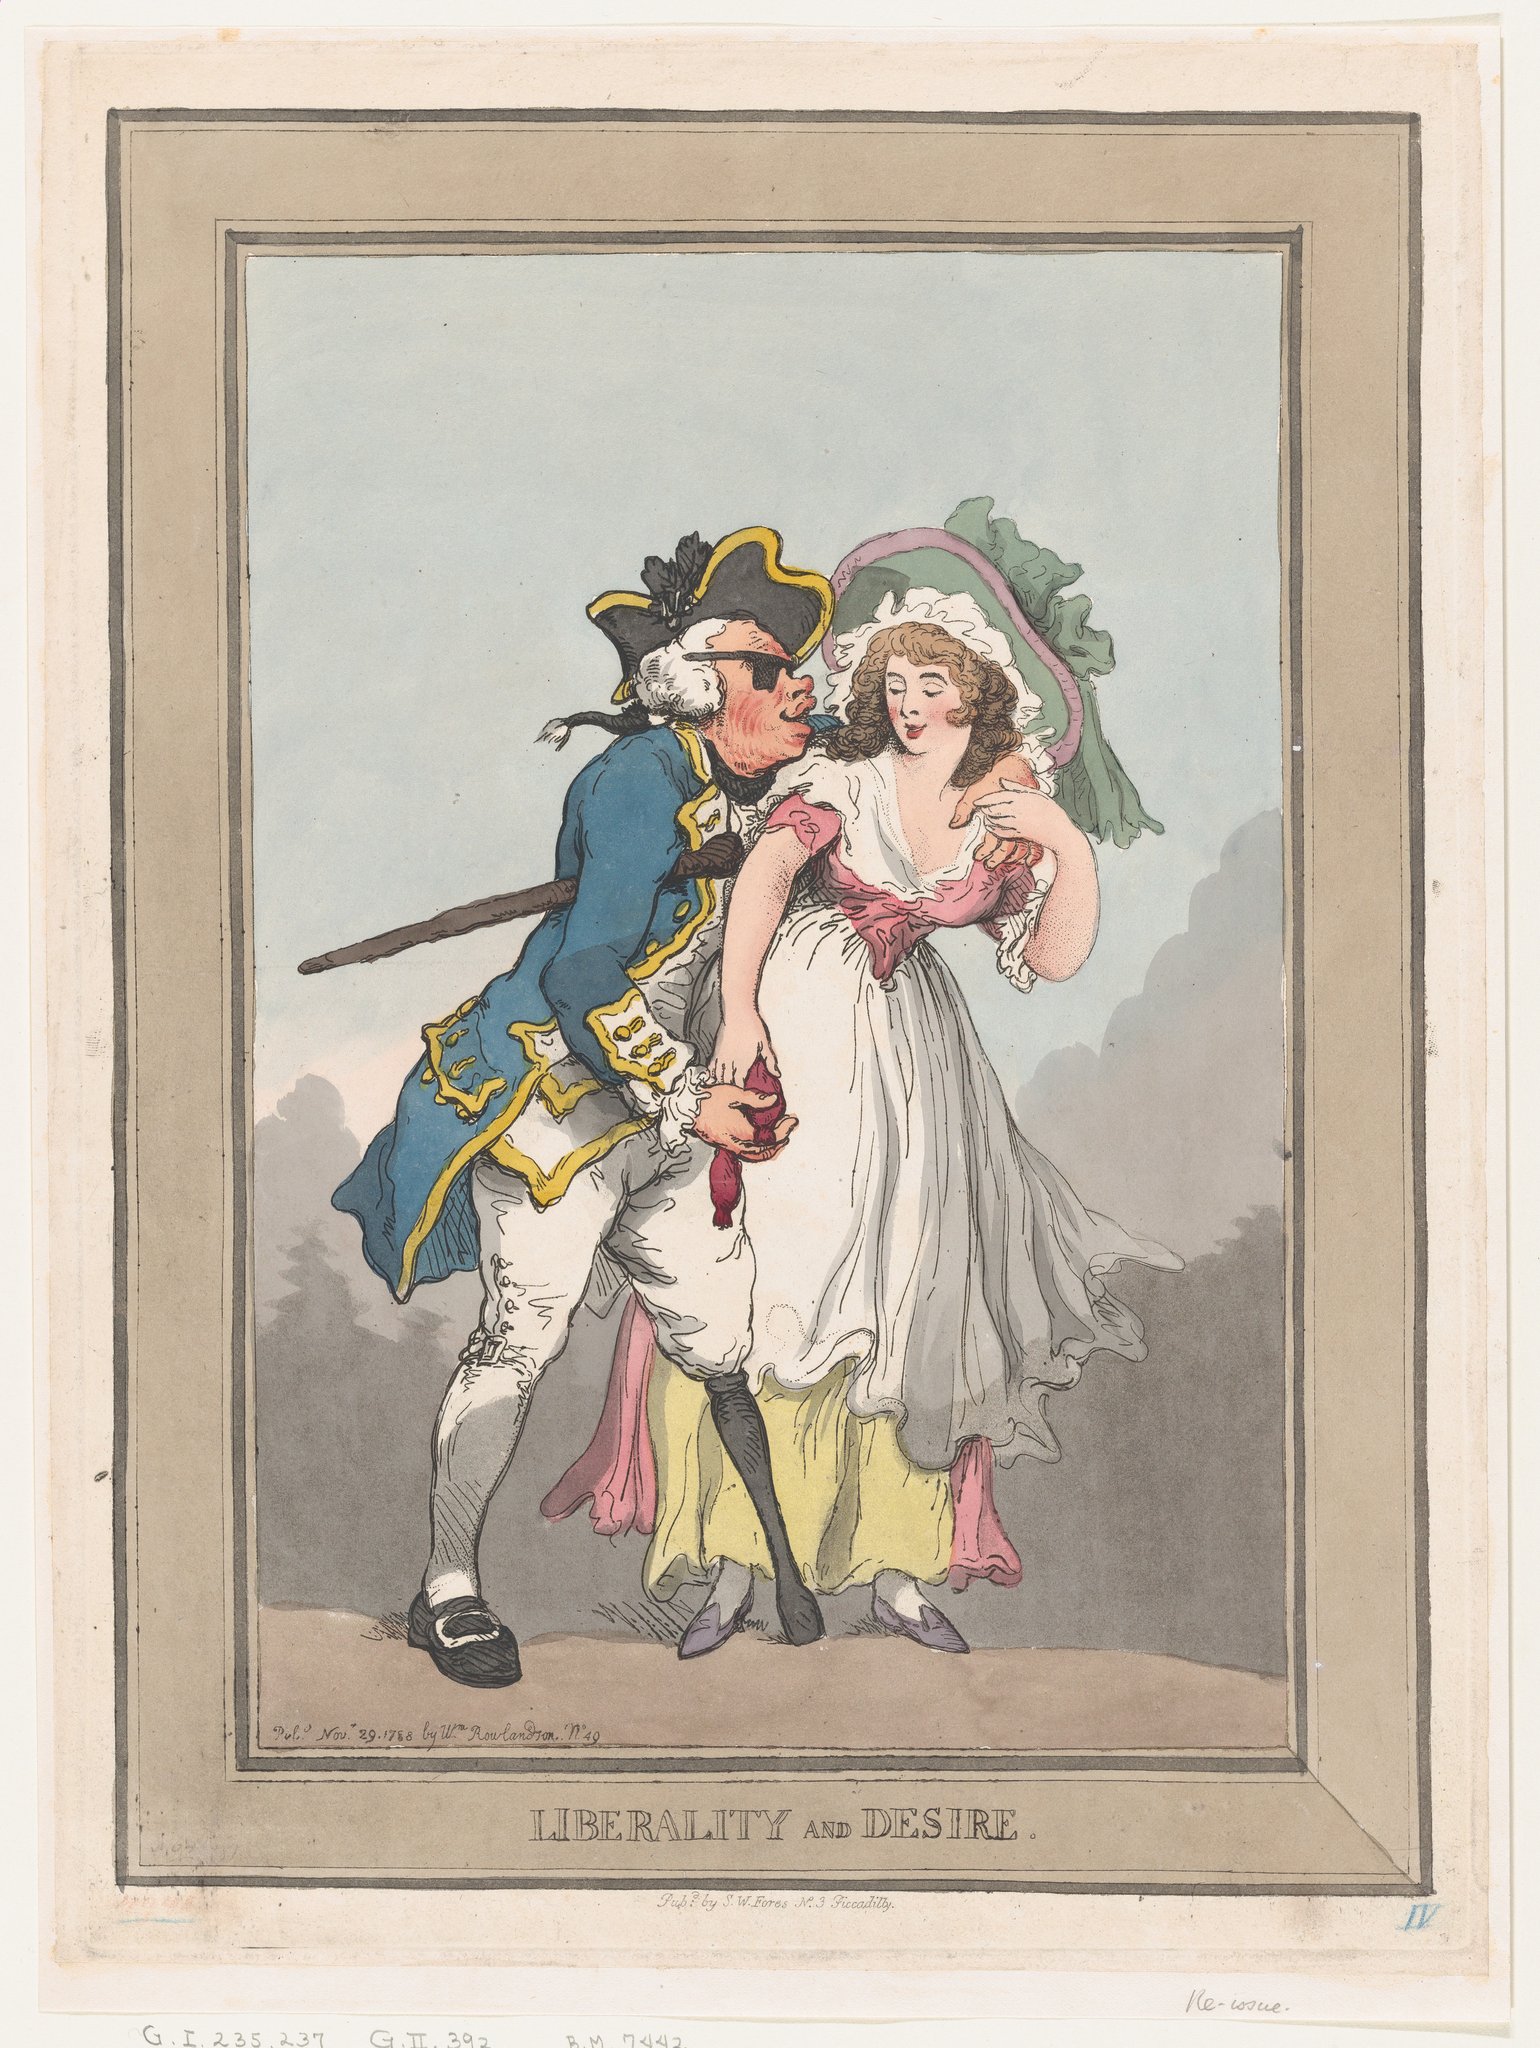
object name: print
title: Liberality and Desire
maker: thomas rowlandson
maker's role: artist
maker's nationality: british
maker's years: 1757-1827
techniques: aquatint, etching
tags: satire,soldiers,men,women